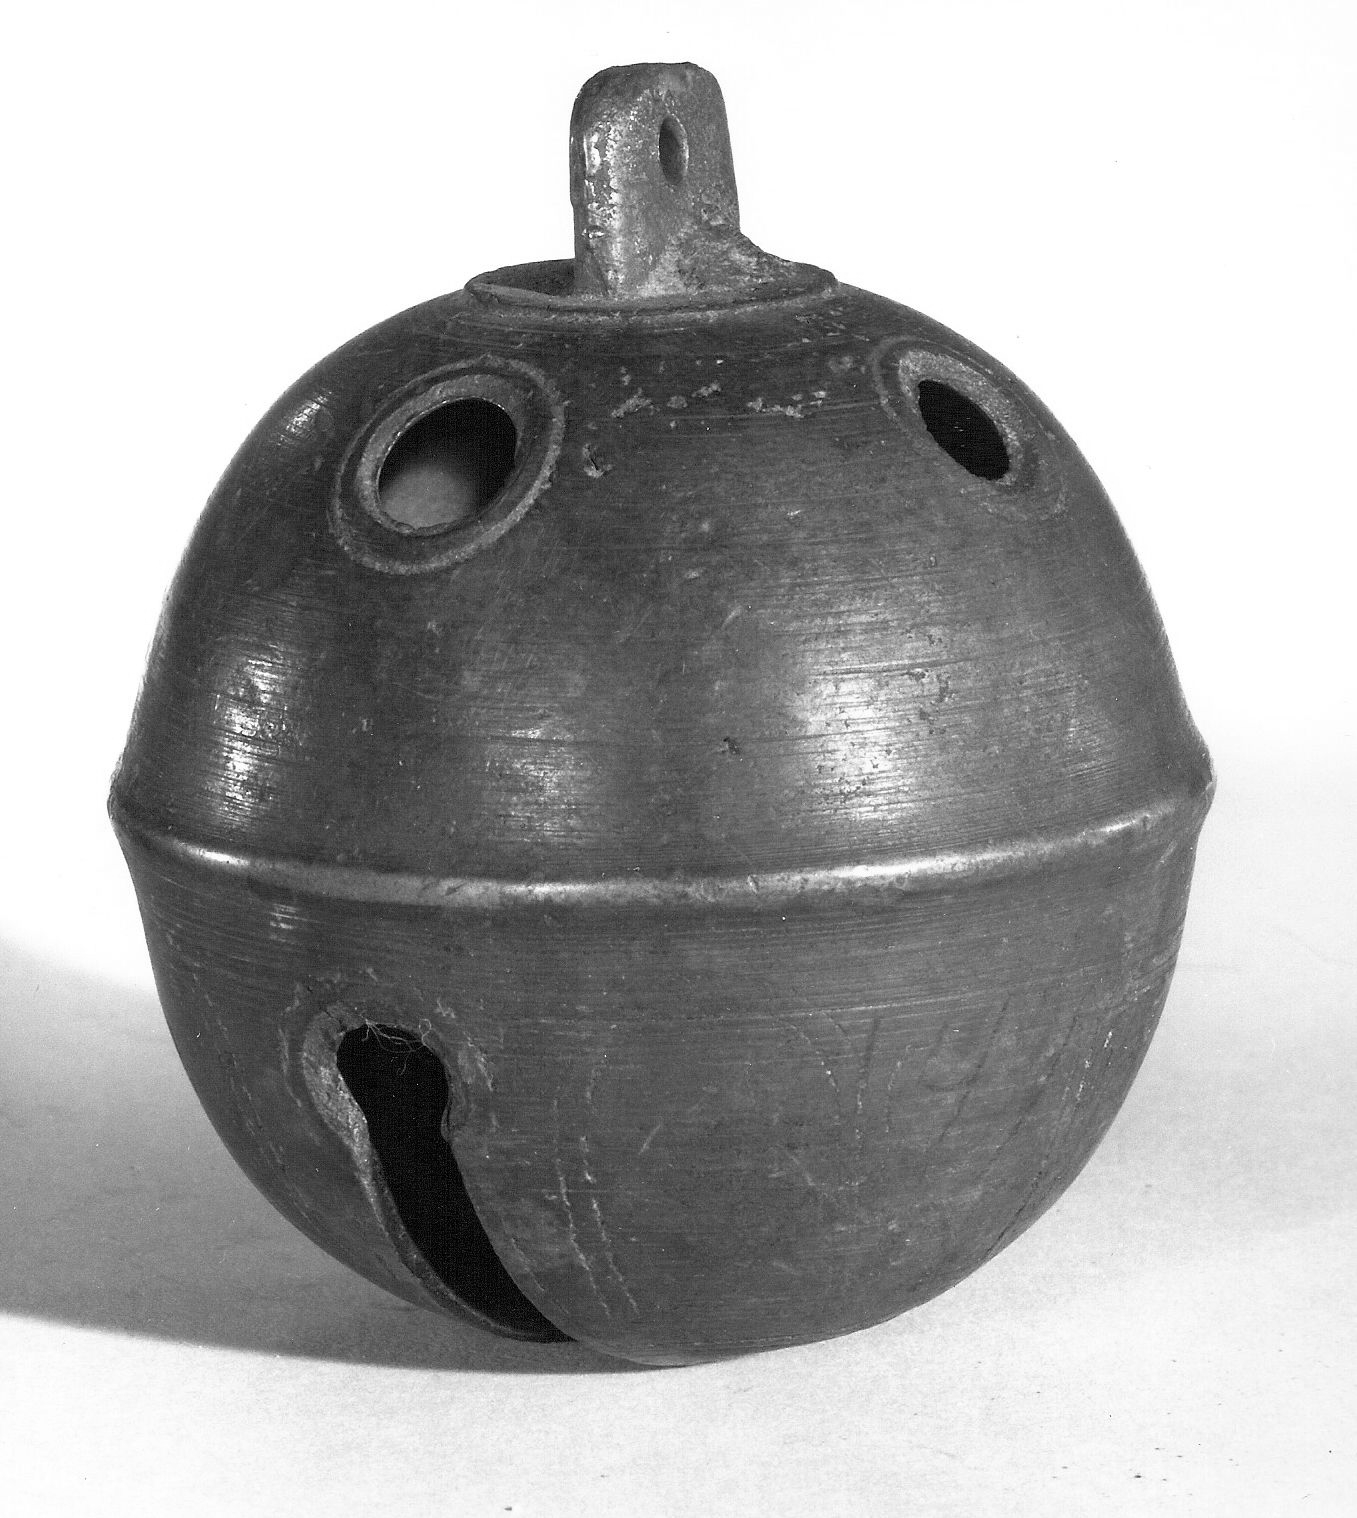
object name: pellet bell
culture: american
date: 1801-1900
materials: bronze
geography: united states